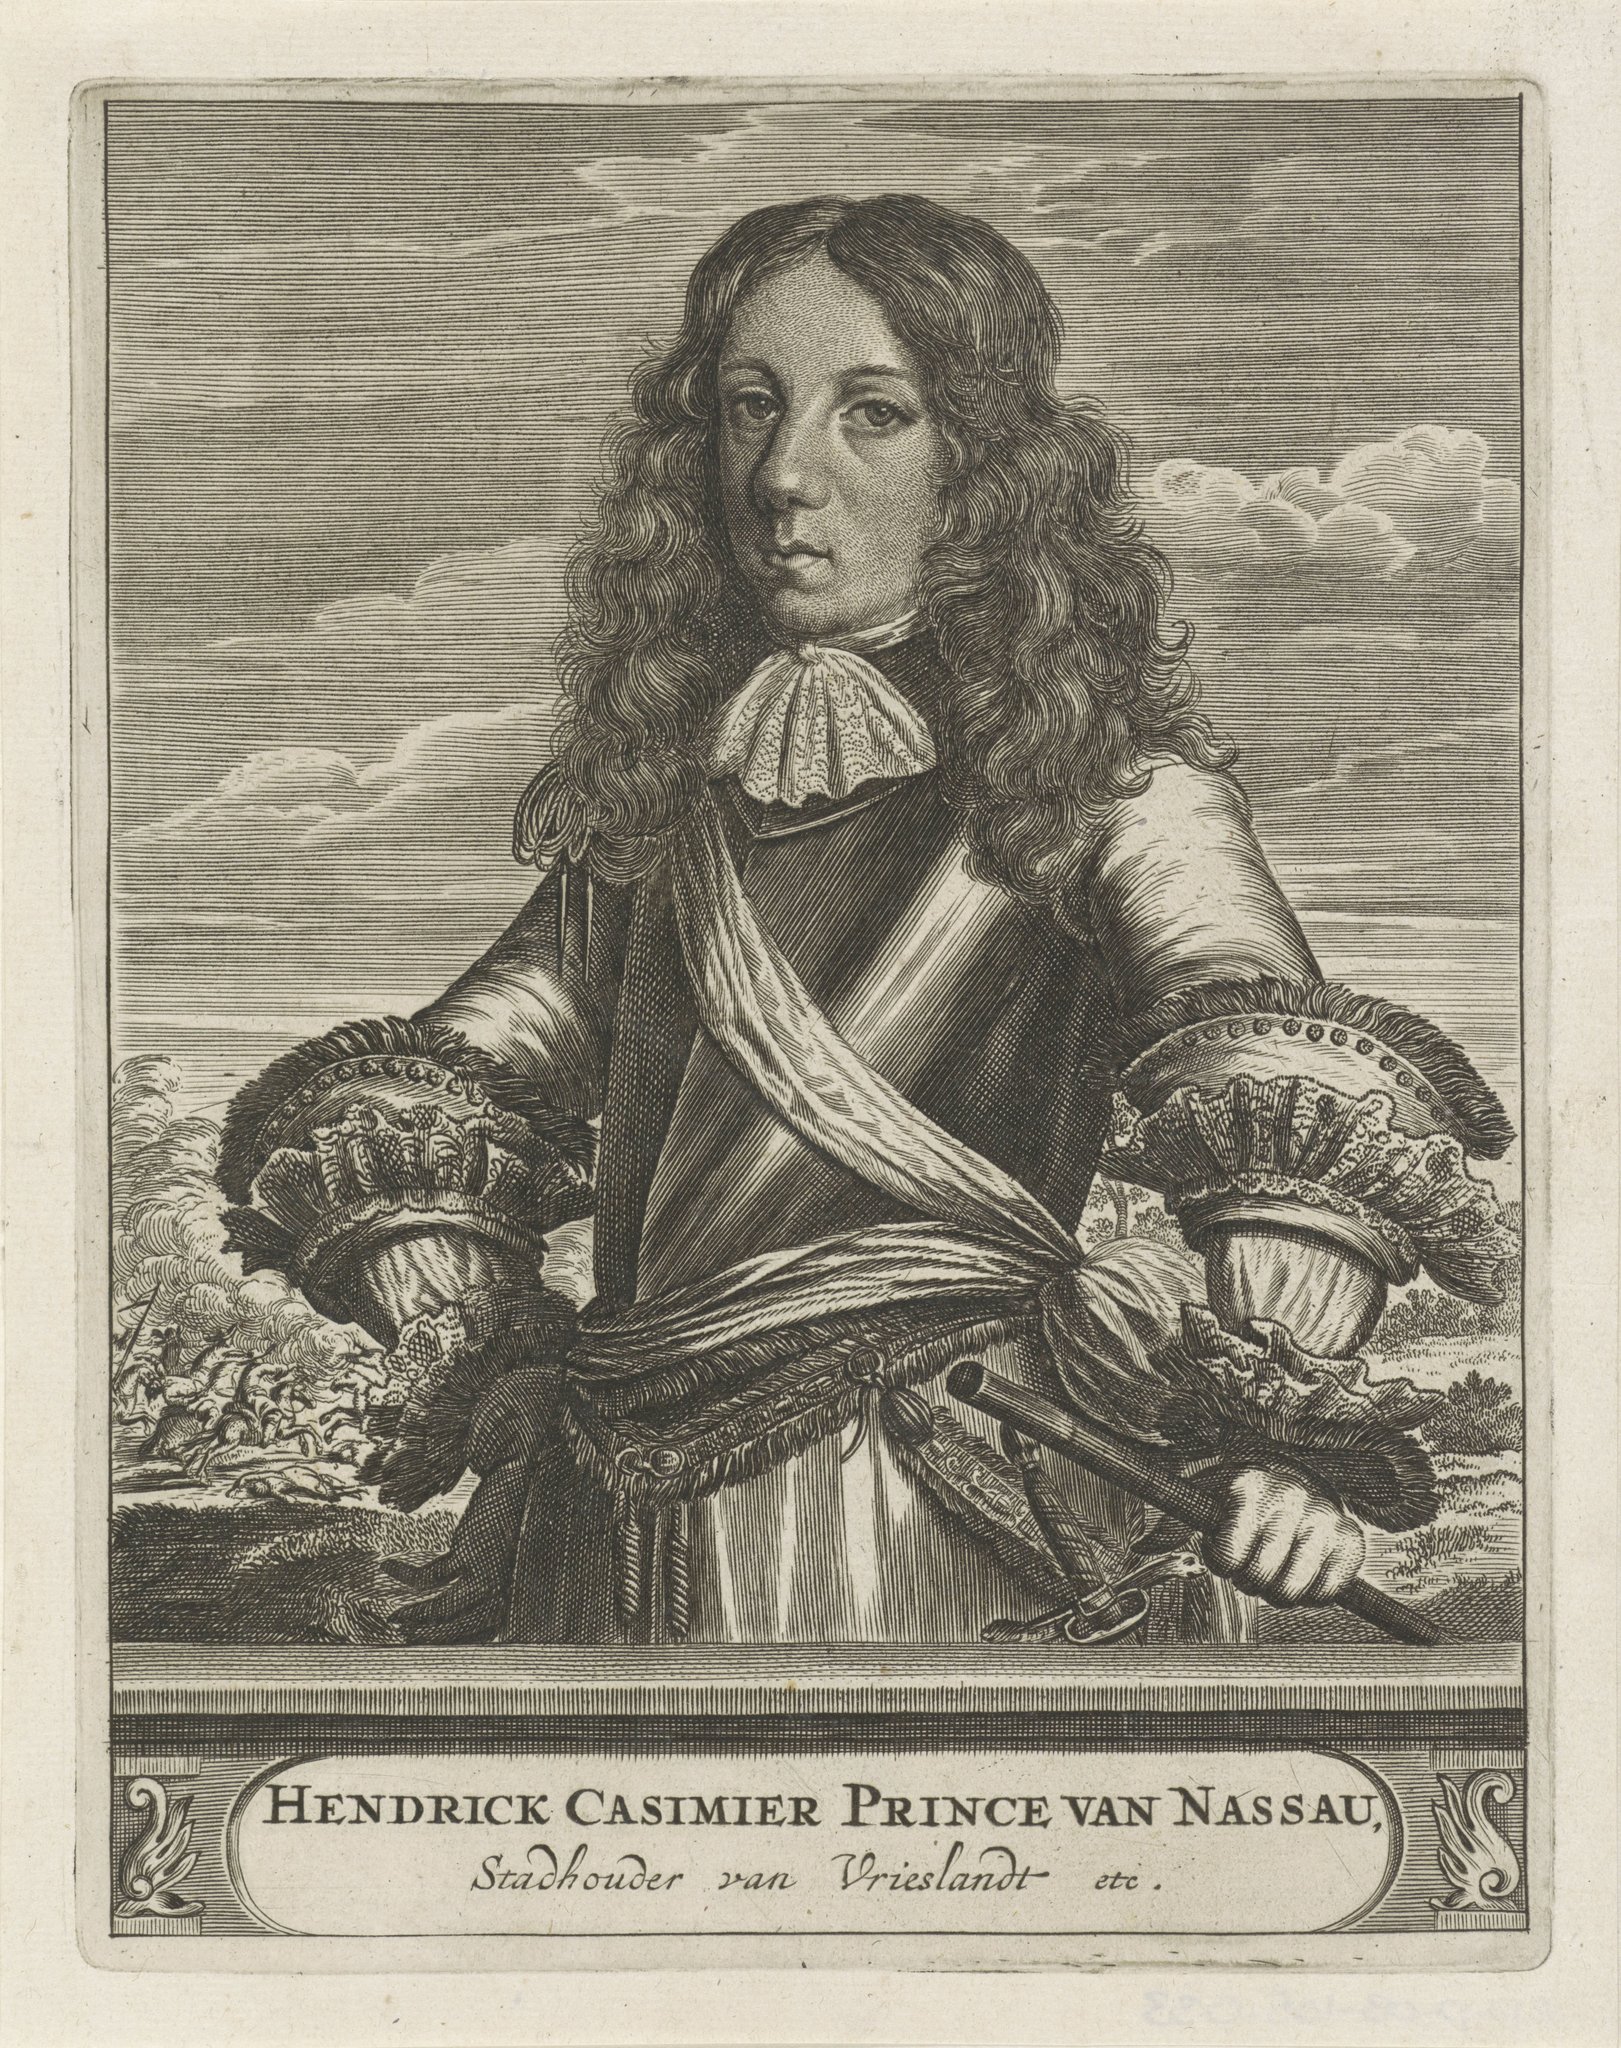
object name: print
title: Portret van Hendrik Casimir II, graaf van Nassau-Dietz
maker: christiaan hagen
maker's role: draughtsman, print maker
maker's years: 1635-1707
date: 1675-1695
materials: paper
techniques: engraving, etching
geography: amsterdam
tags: the hague, hendrik casimir ii graaf van nassau-dietz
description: De hier vermelde titel verwijst naar de hoogst verkregen titel van de geportretteerde, niet per se naar de titel die de geportretteerde op deze voorstelling draagt.